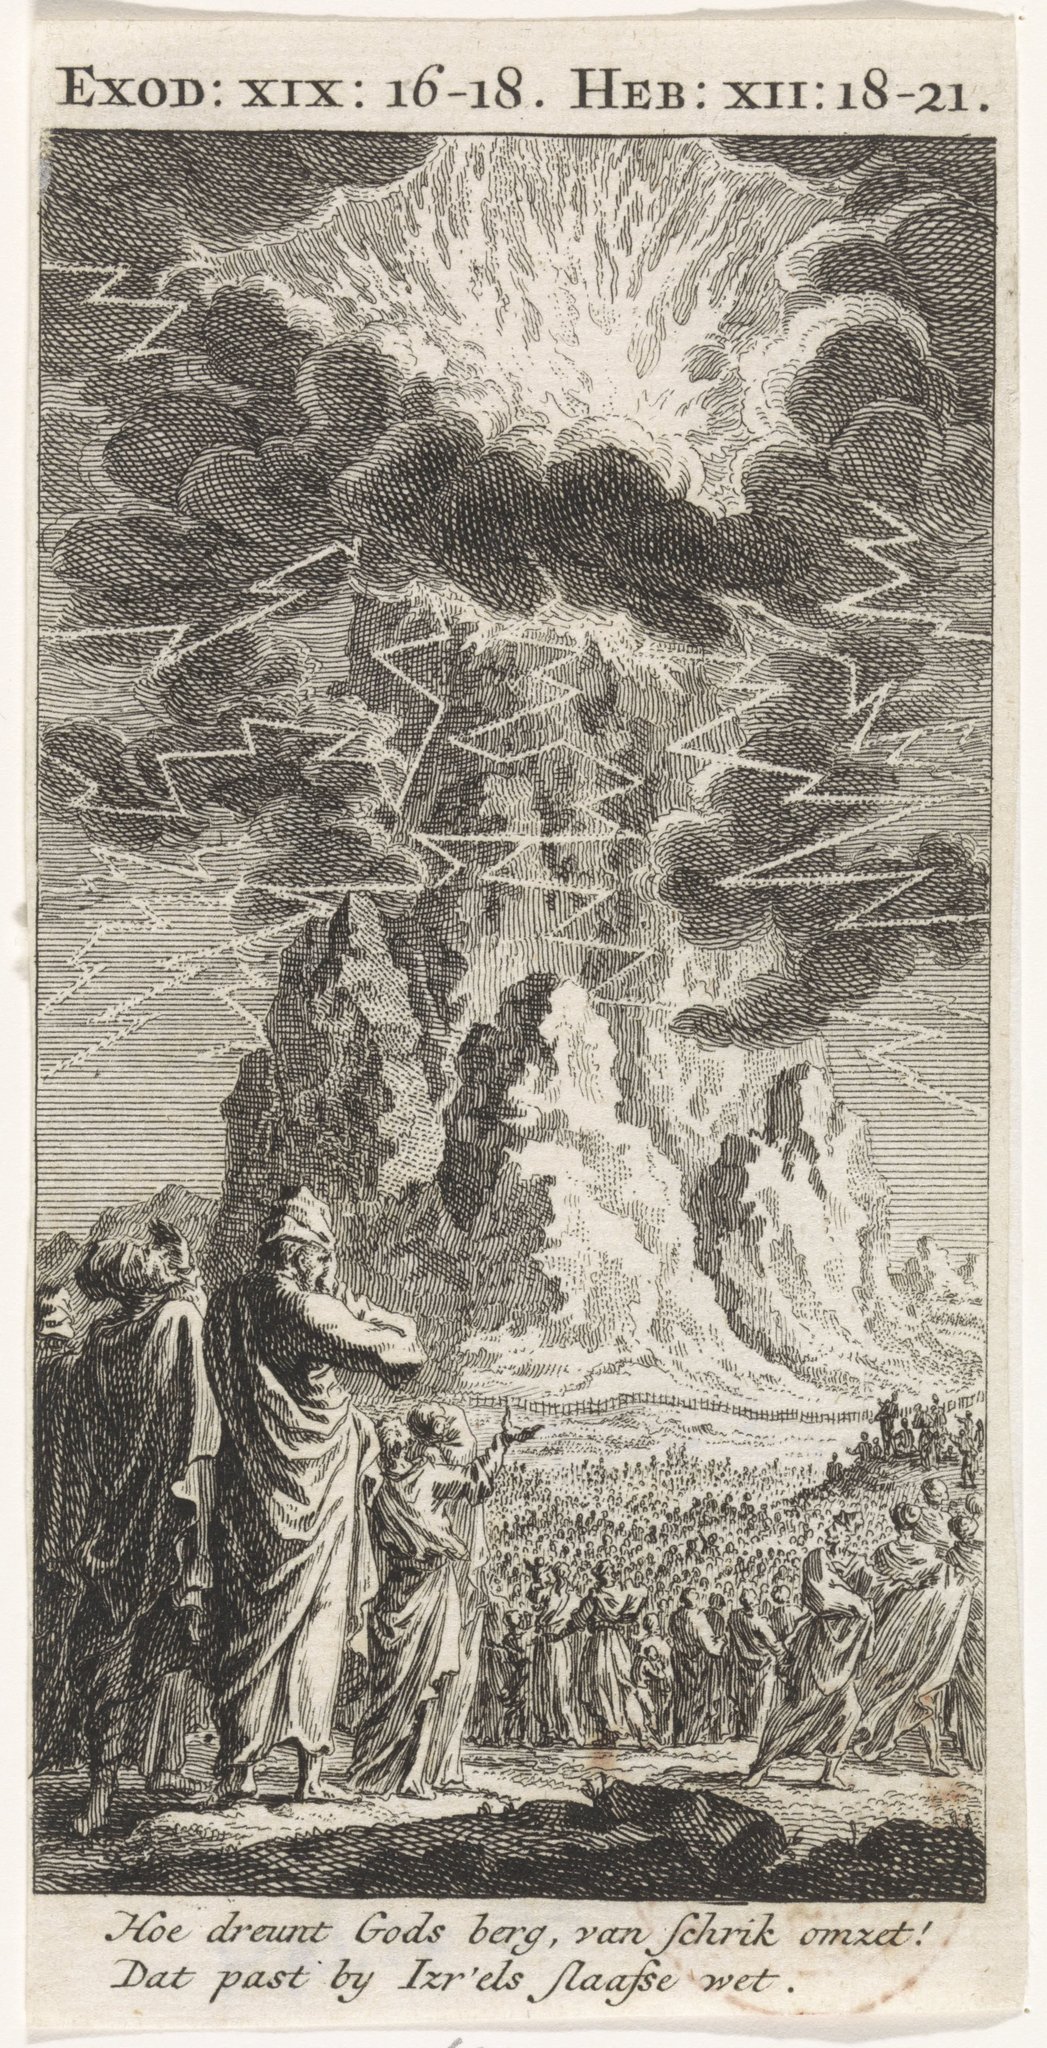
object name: print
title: Wetgeving op de berg Sinaï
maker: Anonymous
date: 1712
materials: paper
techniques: etching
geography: amsterdam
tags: mount sinai is covered by a thick cloud, thunder and lightning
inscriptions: collector's mark: Lugt 240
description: Kopie naar illustratie voor: Luyken, Jan. Bybel printen. Amsterdam: Pieter Arentsz. II (wed.) en Cornelis van der Sys, 1712, p. 6.